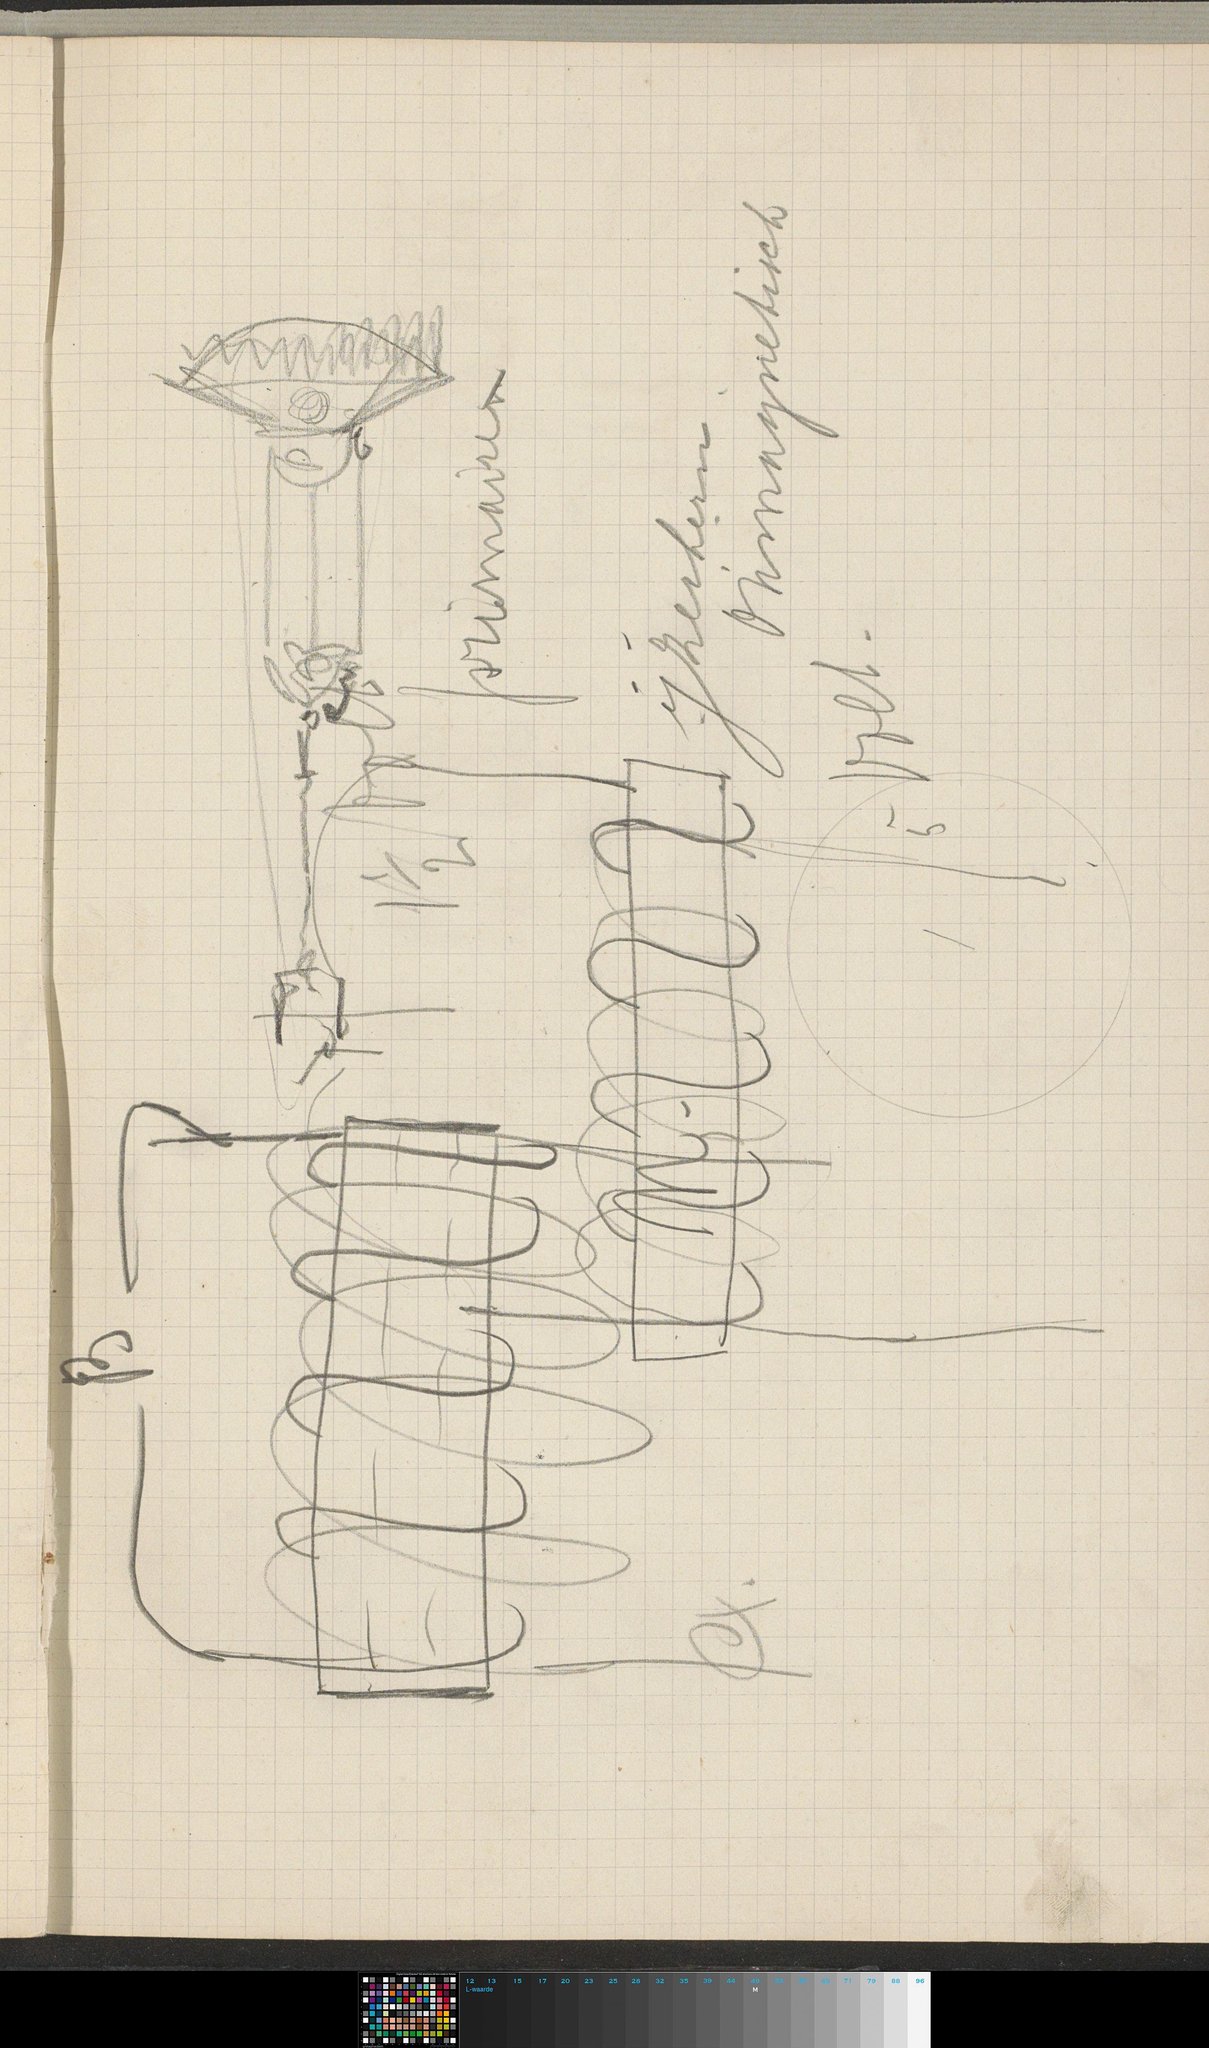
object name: sketchbook leaf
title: Ontwerp voor een hanglamp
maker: carel adolph lion cachet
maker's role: draughtsman, print maker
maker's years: 1864-1945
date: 1874-1945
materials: pencil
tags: lighting; lamps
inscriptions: annotation: ‘1 1/2/ primaire[...]/ ijzerkern/ [....]magnetisch/ 5 volt’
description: Blad 9 recto uit een schetsboek met 9 bladen.